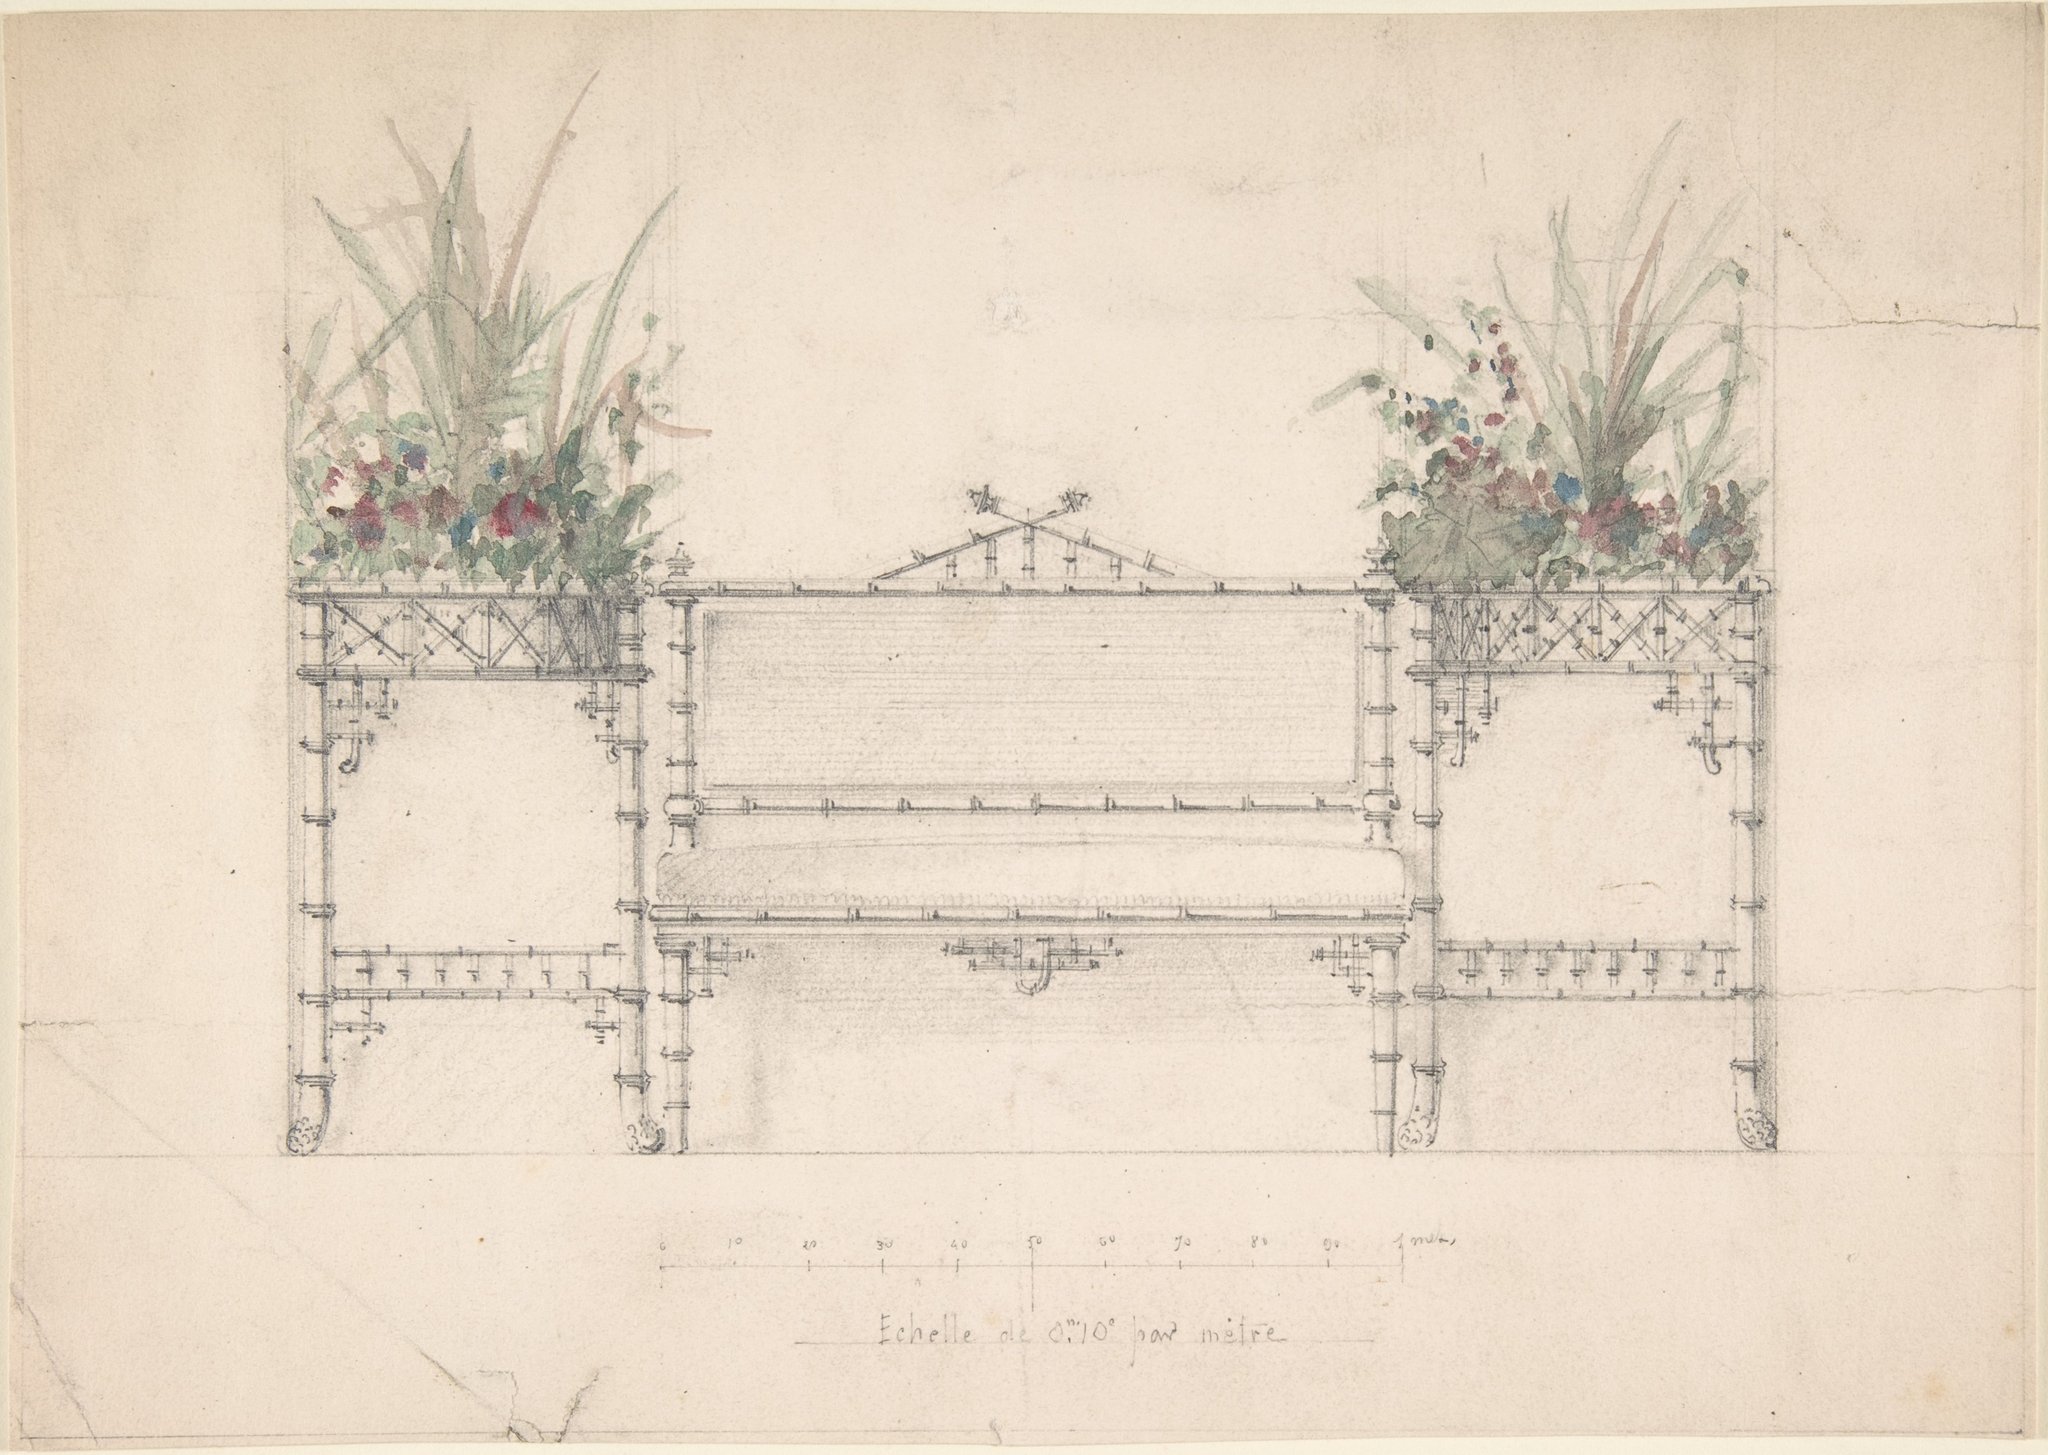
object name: drawing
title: Design for Chinois Bench and Planters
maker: anonymous, french, 19th century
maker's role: artist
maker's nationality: french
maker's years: 1800-1900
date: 1801-1900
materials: graphite, watercolor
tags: flowers,leaves